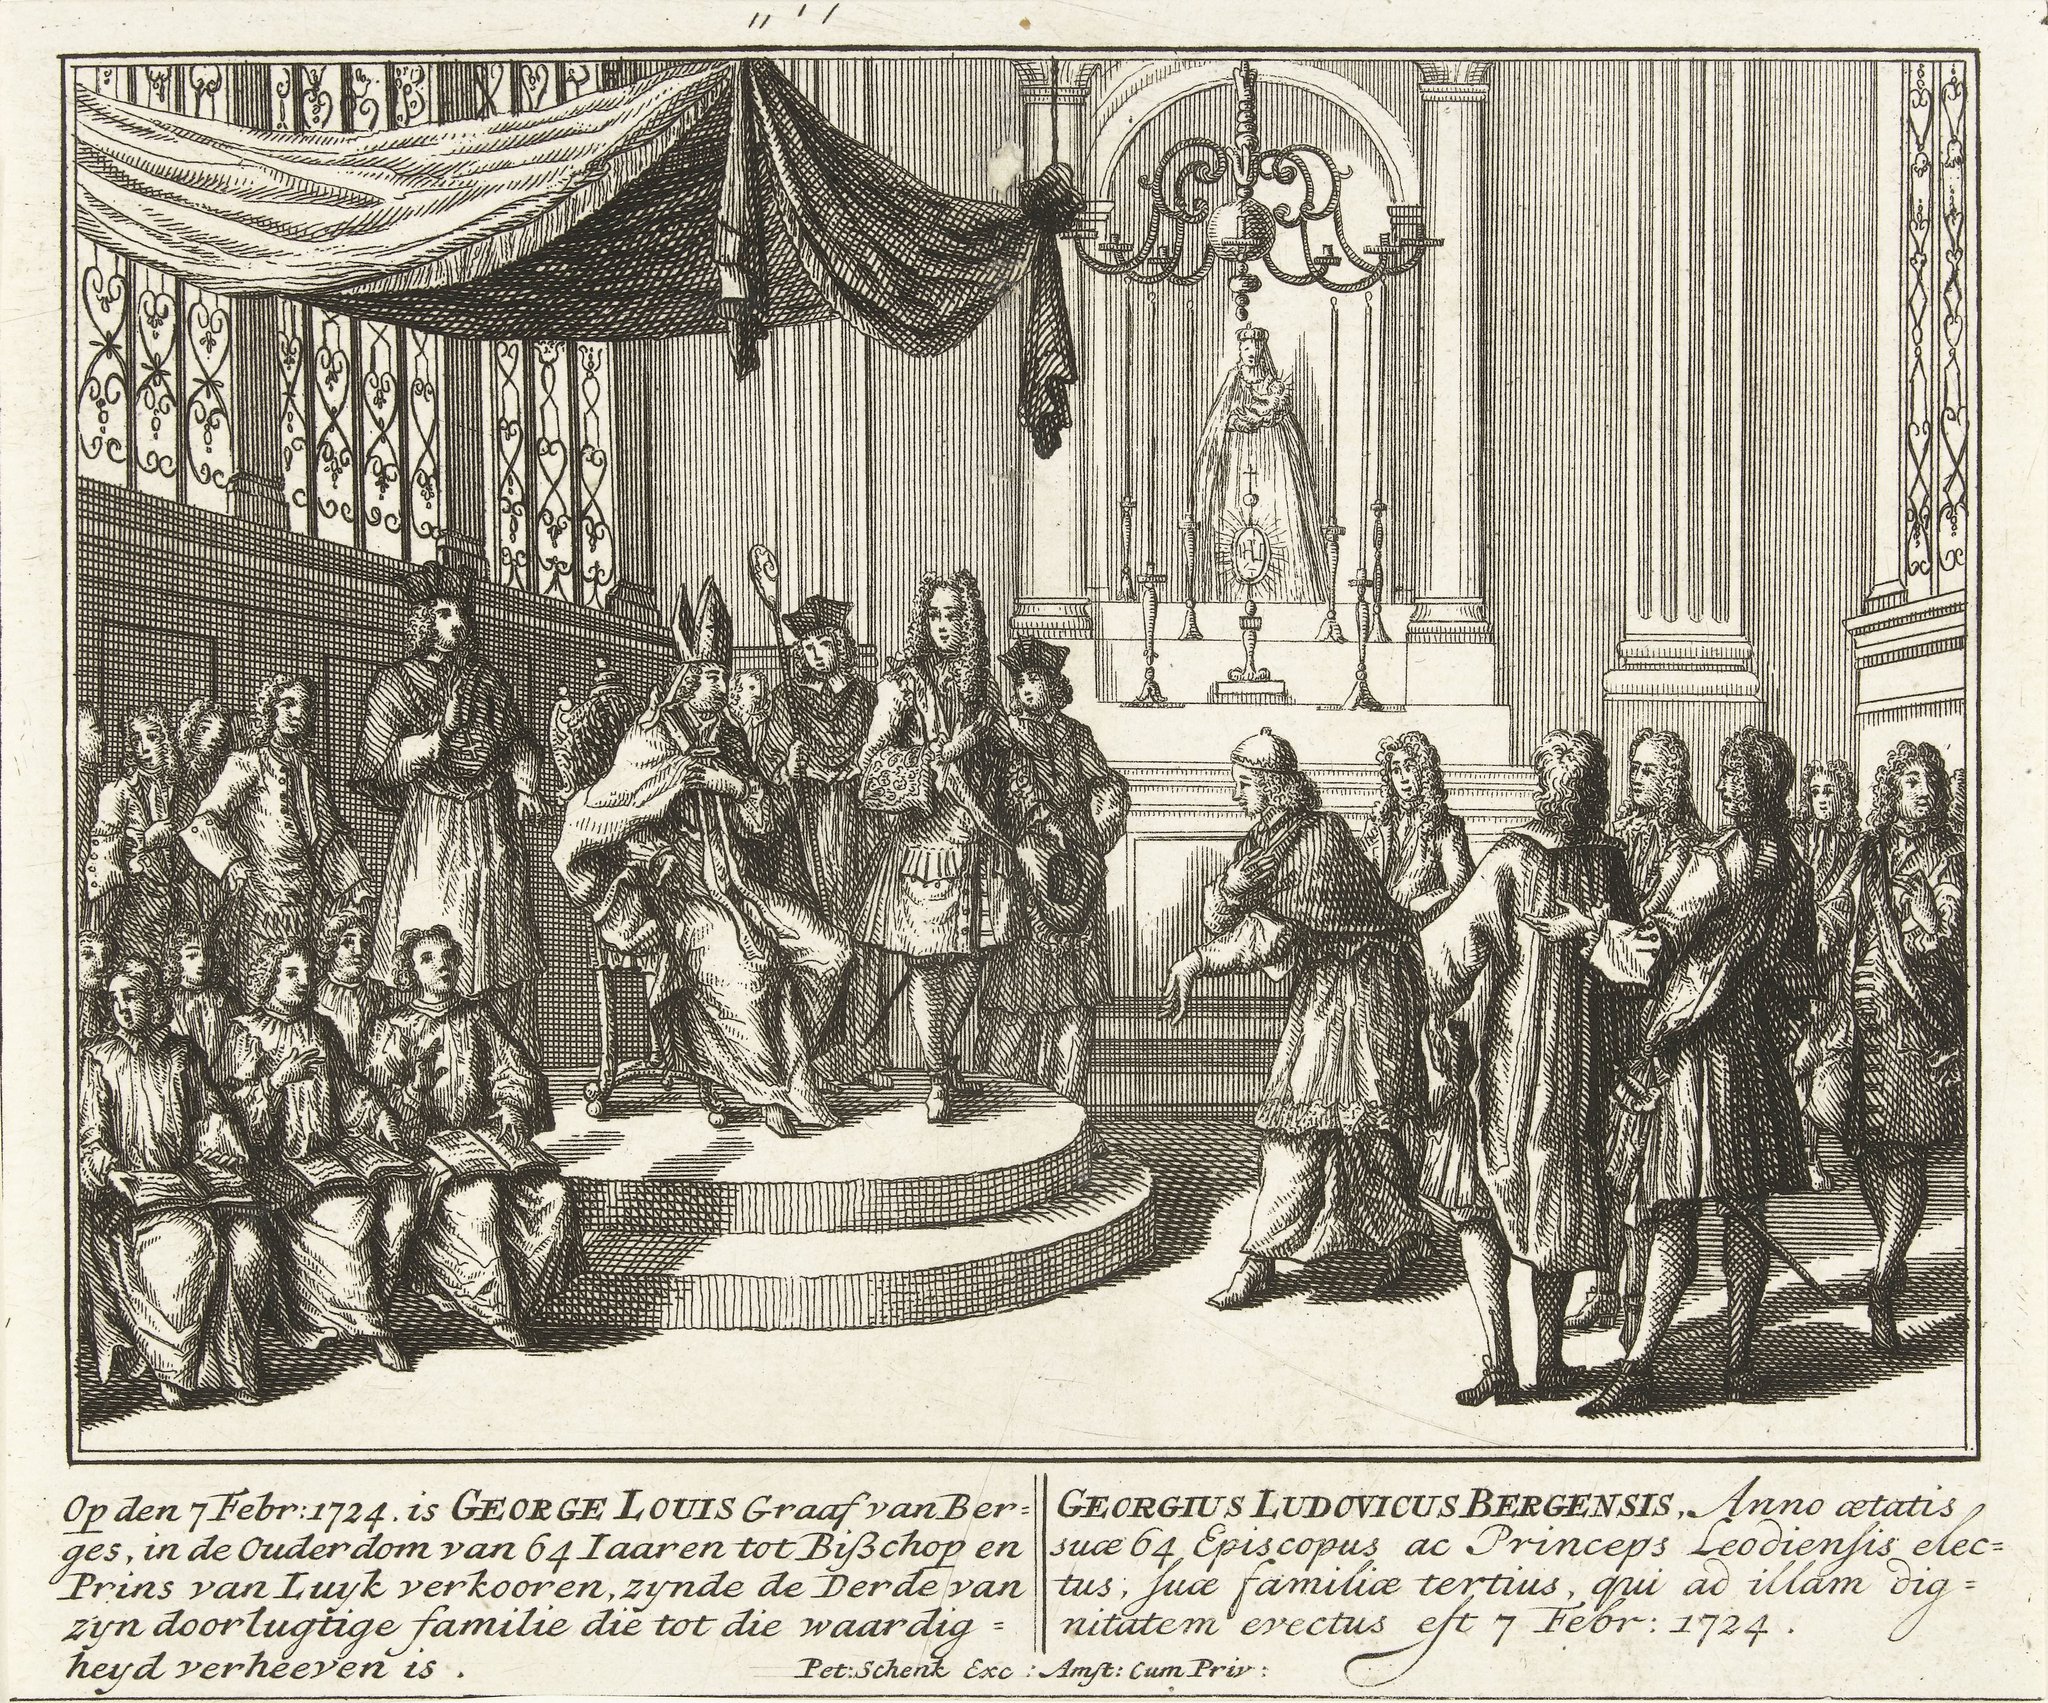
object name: history print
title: Aanstelling van George Louis Graaf van Berges tot prins-bisschop van Luik, 1724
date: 1724-1727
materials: paper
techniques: etching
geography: northern netherlands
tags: inauguration, consecration of person(s) ~ church, installation of a ruler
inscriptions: collector's mark: Lugt 2228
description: Dit nummer is een door het RPK toegevoegd nummer en staat niet in Frederik Muller, het werk waar de prent voor is gemaakt of uit afkomstig is, staat wel vermeld in Frederik Muller. Gebruikt als illustratie in: Schouwtoneel van den oorlog ..., J. Roman, Amsterdam 1727.